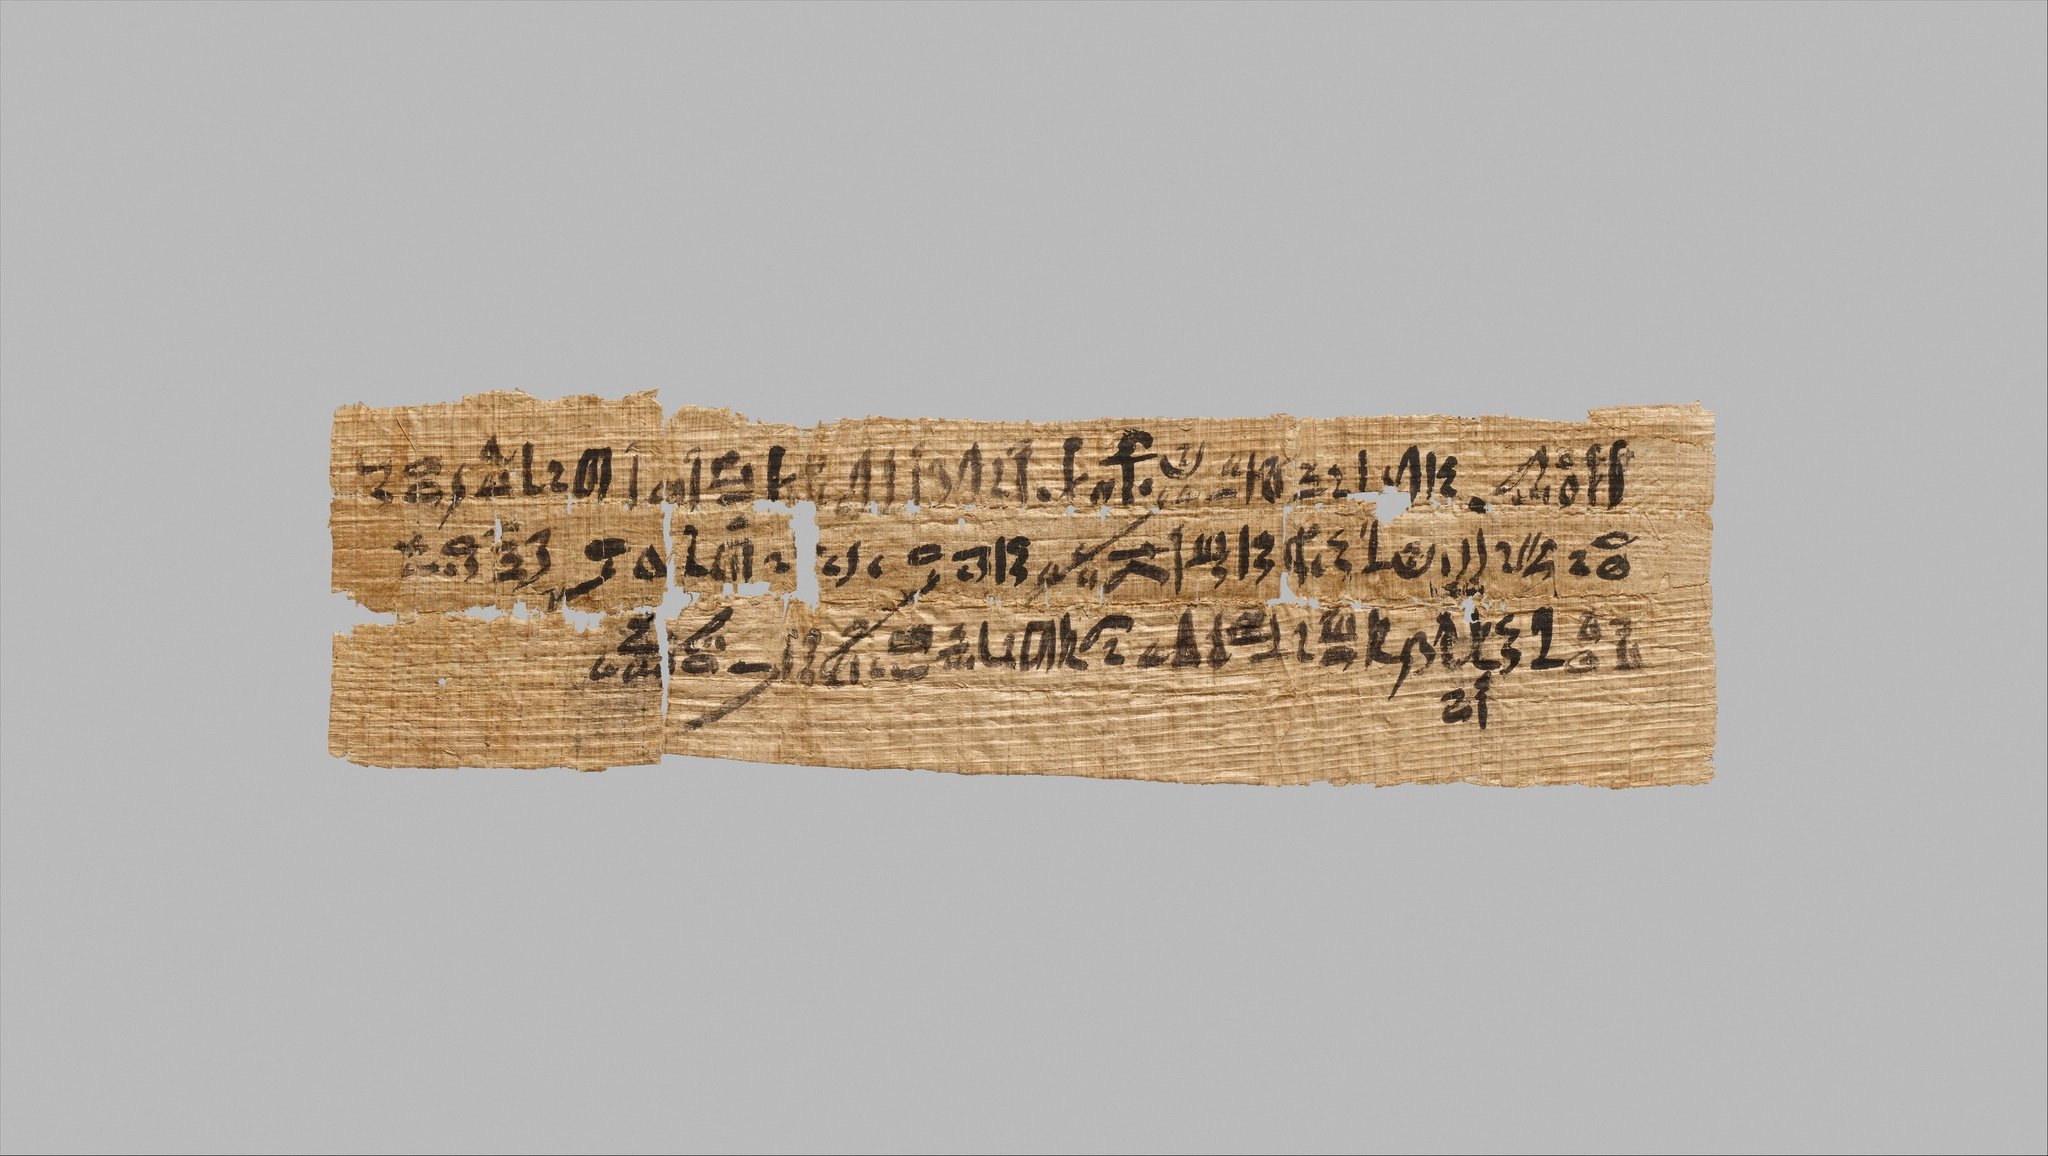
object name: papyrus, letter, hieratic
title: Letter written in hieratic script on papyrus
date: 1479-1458 BCE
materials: ink, papyrus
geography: egypt